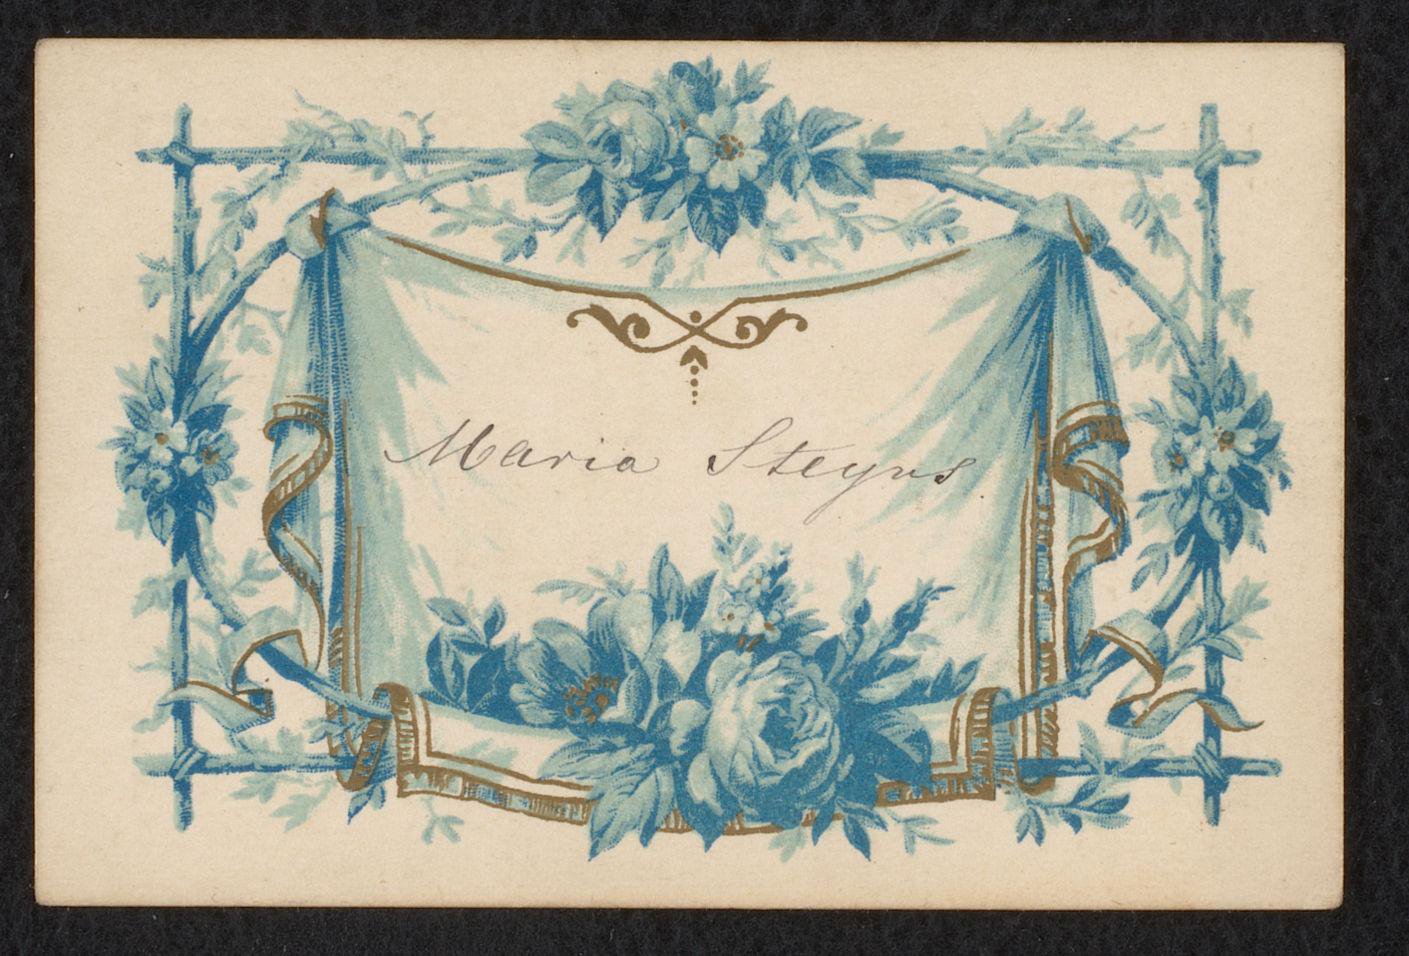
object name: menu, menukaart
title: Menu van een diner op 18 maart 1888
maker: Anonymous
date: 1888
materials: paper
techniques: chromolithography, letterpress printing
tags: flowers: rose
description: Op de voorzijde, hangt in het midden van een decoratief kader van rozen een laken met daarop de naam 'Maria Steyns' in handschrift. Op de achterzijde, binnen een decoratief kader, het menu van het diner.